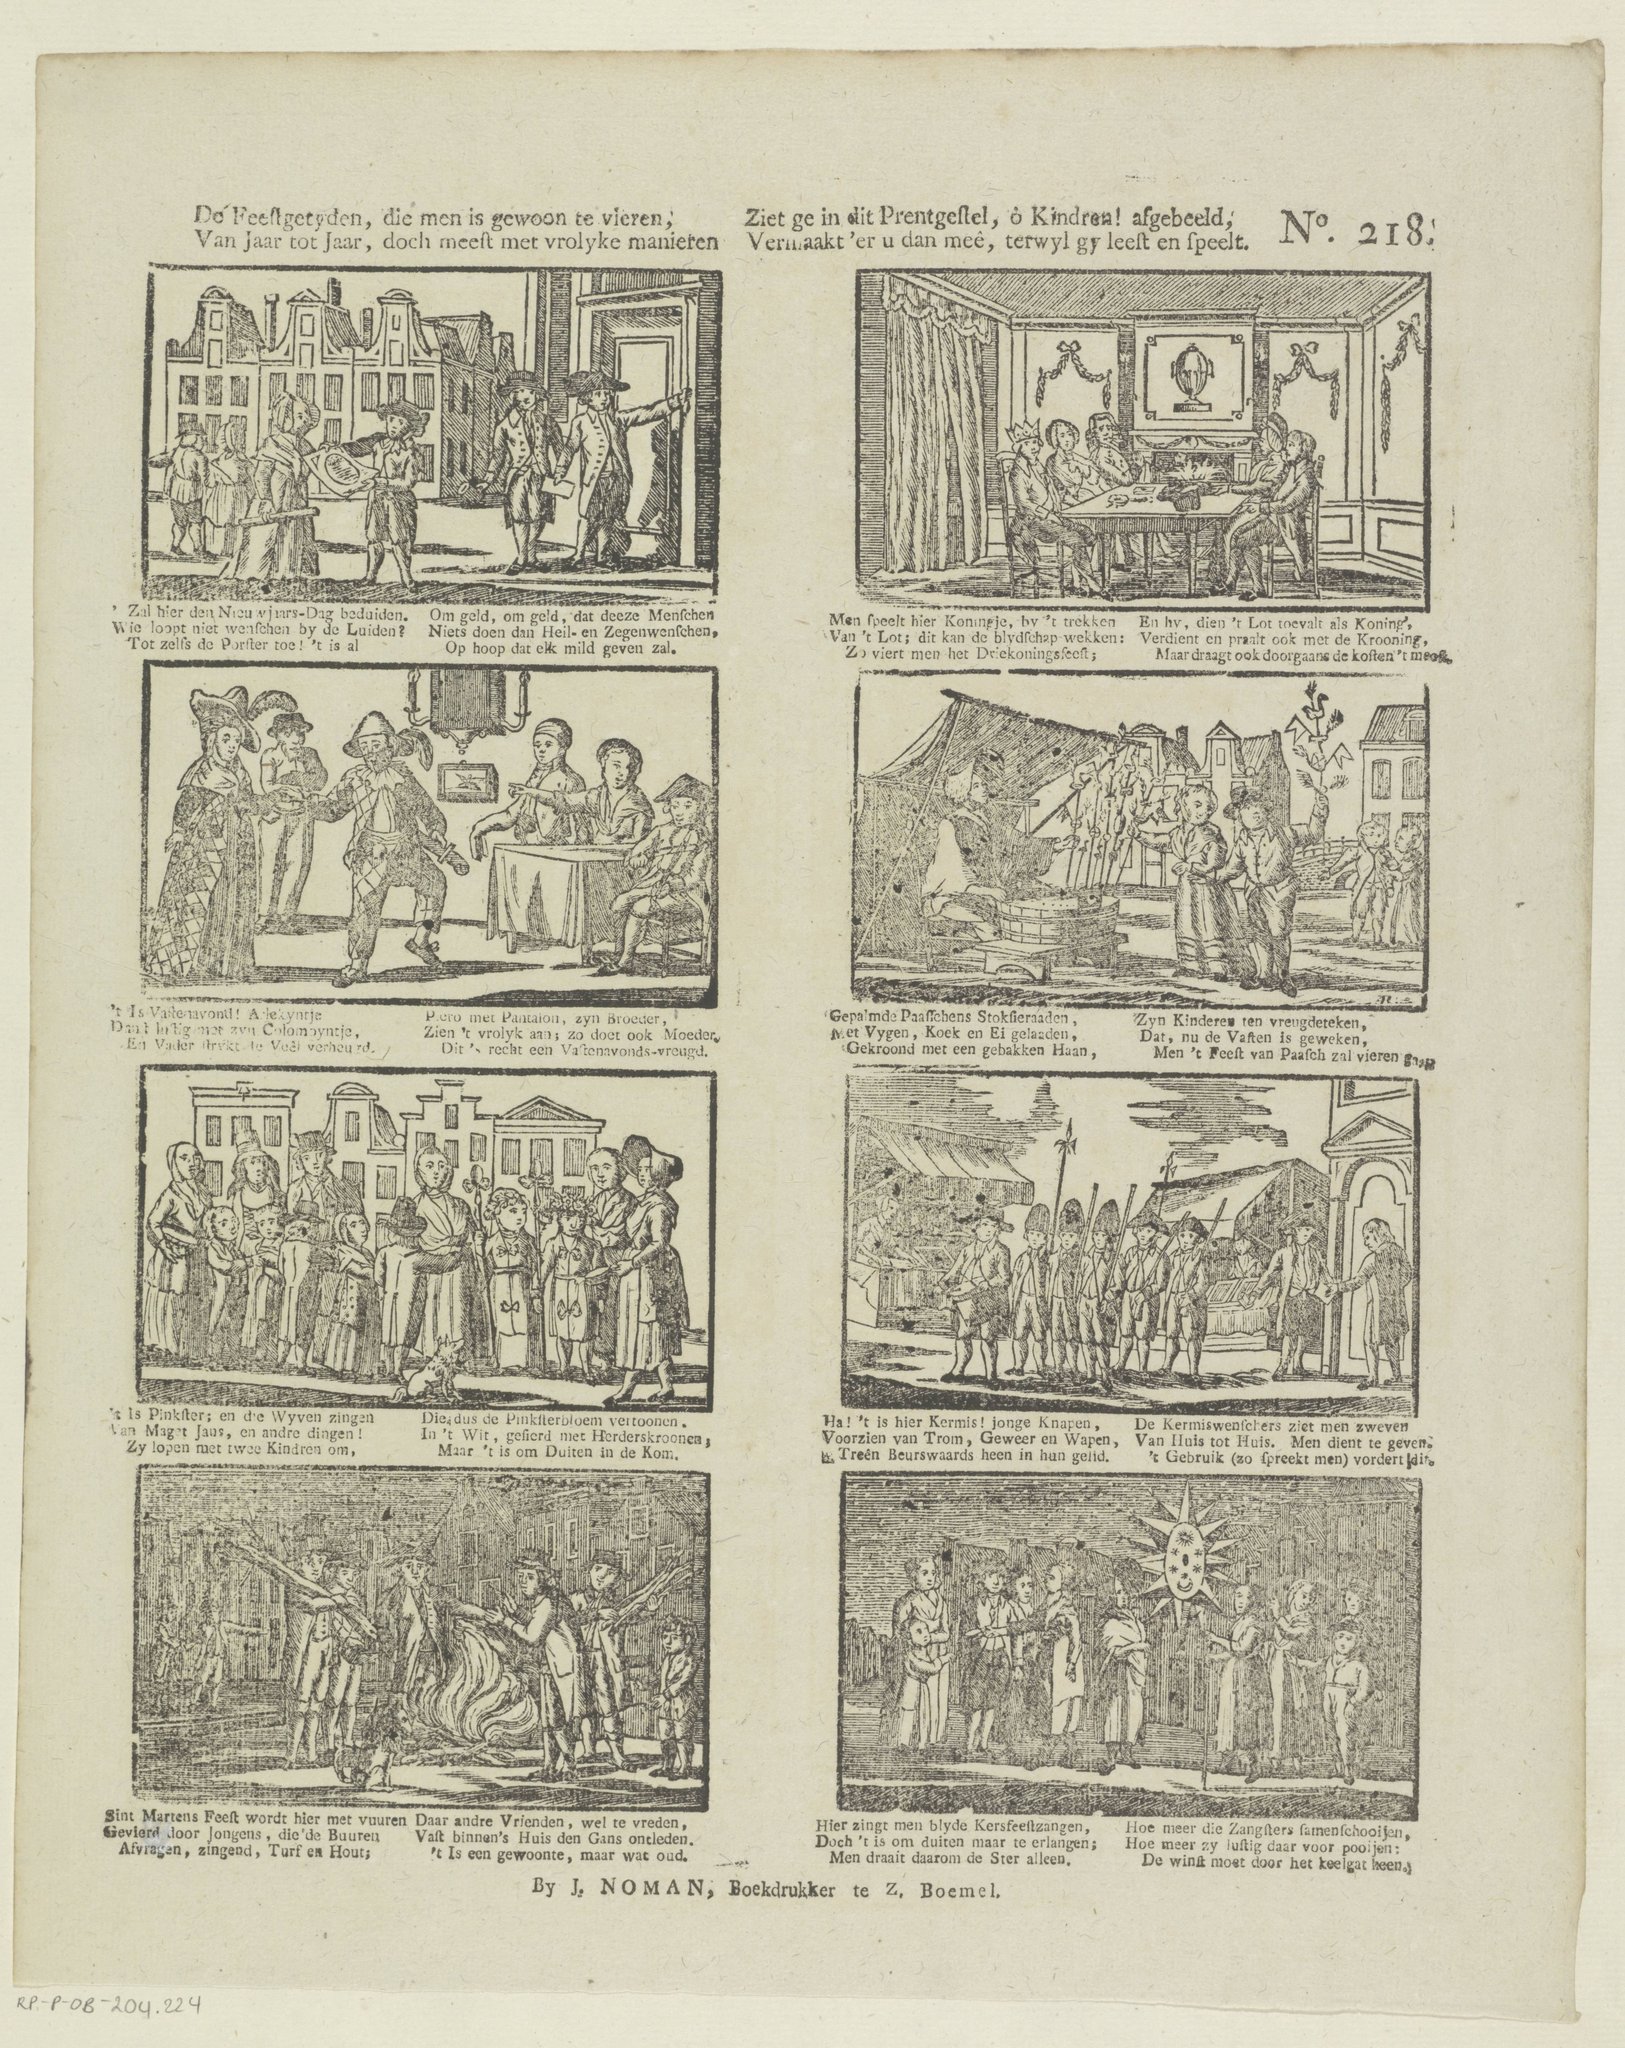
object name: print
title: De feestgetyden, die men is gewoon te vieren, / Van jaar tot jaar, doch men heeft met vrolyke manieren / Ziet ge in dit prentgestel, ô kindren! afgebeeld, / Vermaakt 'er u dan meê, terwyl gy leest en speelt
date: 1806-1830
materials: paper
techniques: letterpress printing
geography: zaltbommel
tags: christmas (ecclesiastical feast), palm sunday, pentecost, whitsunday, st. martin's day (november 11), pleasure fair and circus, january 1 (~ festivities), epiphany, shrove tuesday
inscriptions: collector's mark: Lugt 2760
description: Blad met 8 voorstellingen van de kalenderfeesten: Nieuwjaar, Driekoningen, Vastenavond, Palmpasen, Pinksteren, kermis, Sint-Maarten en Kerstmis. Onder elke voorstelling een vers in twee kolommen. Genummerd rechtsboven: No. 218.